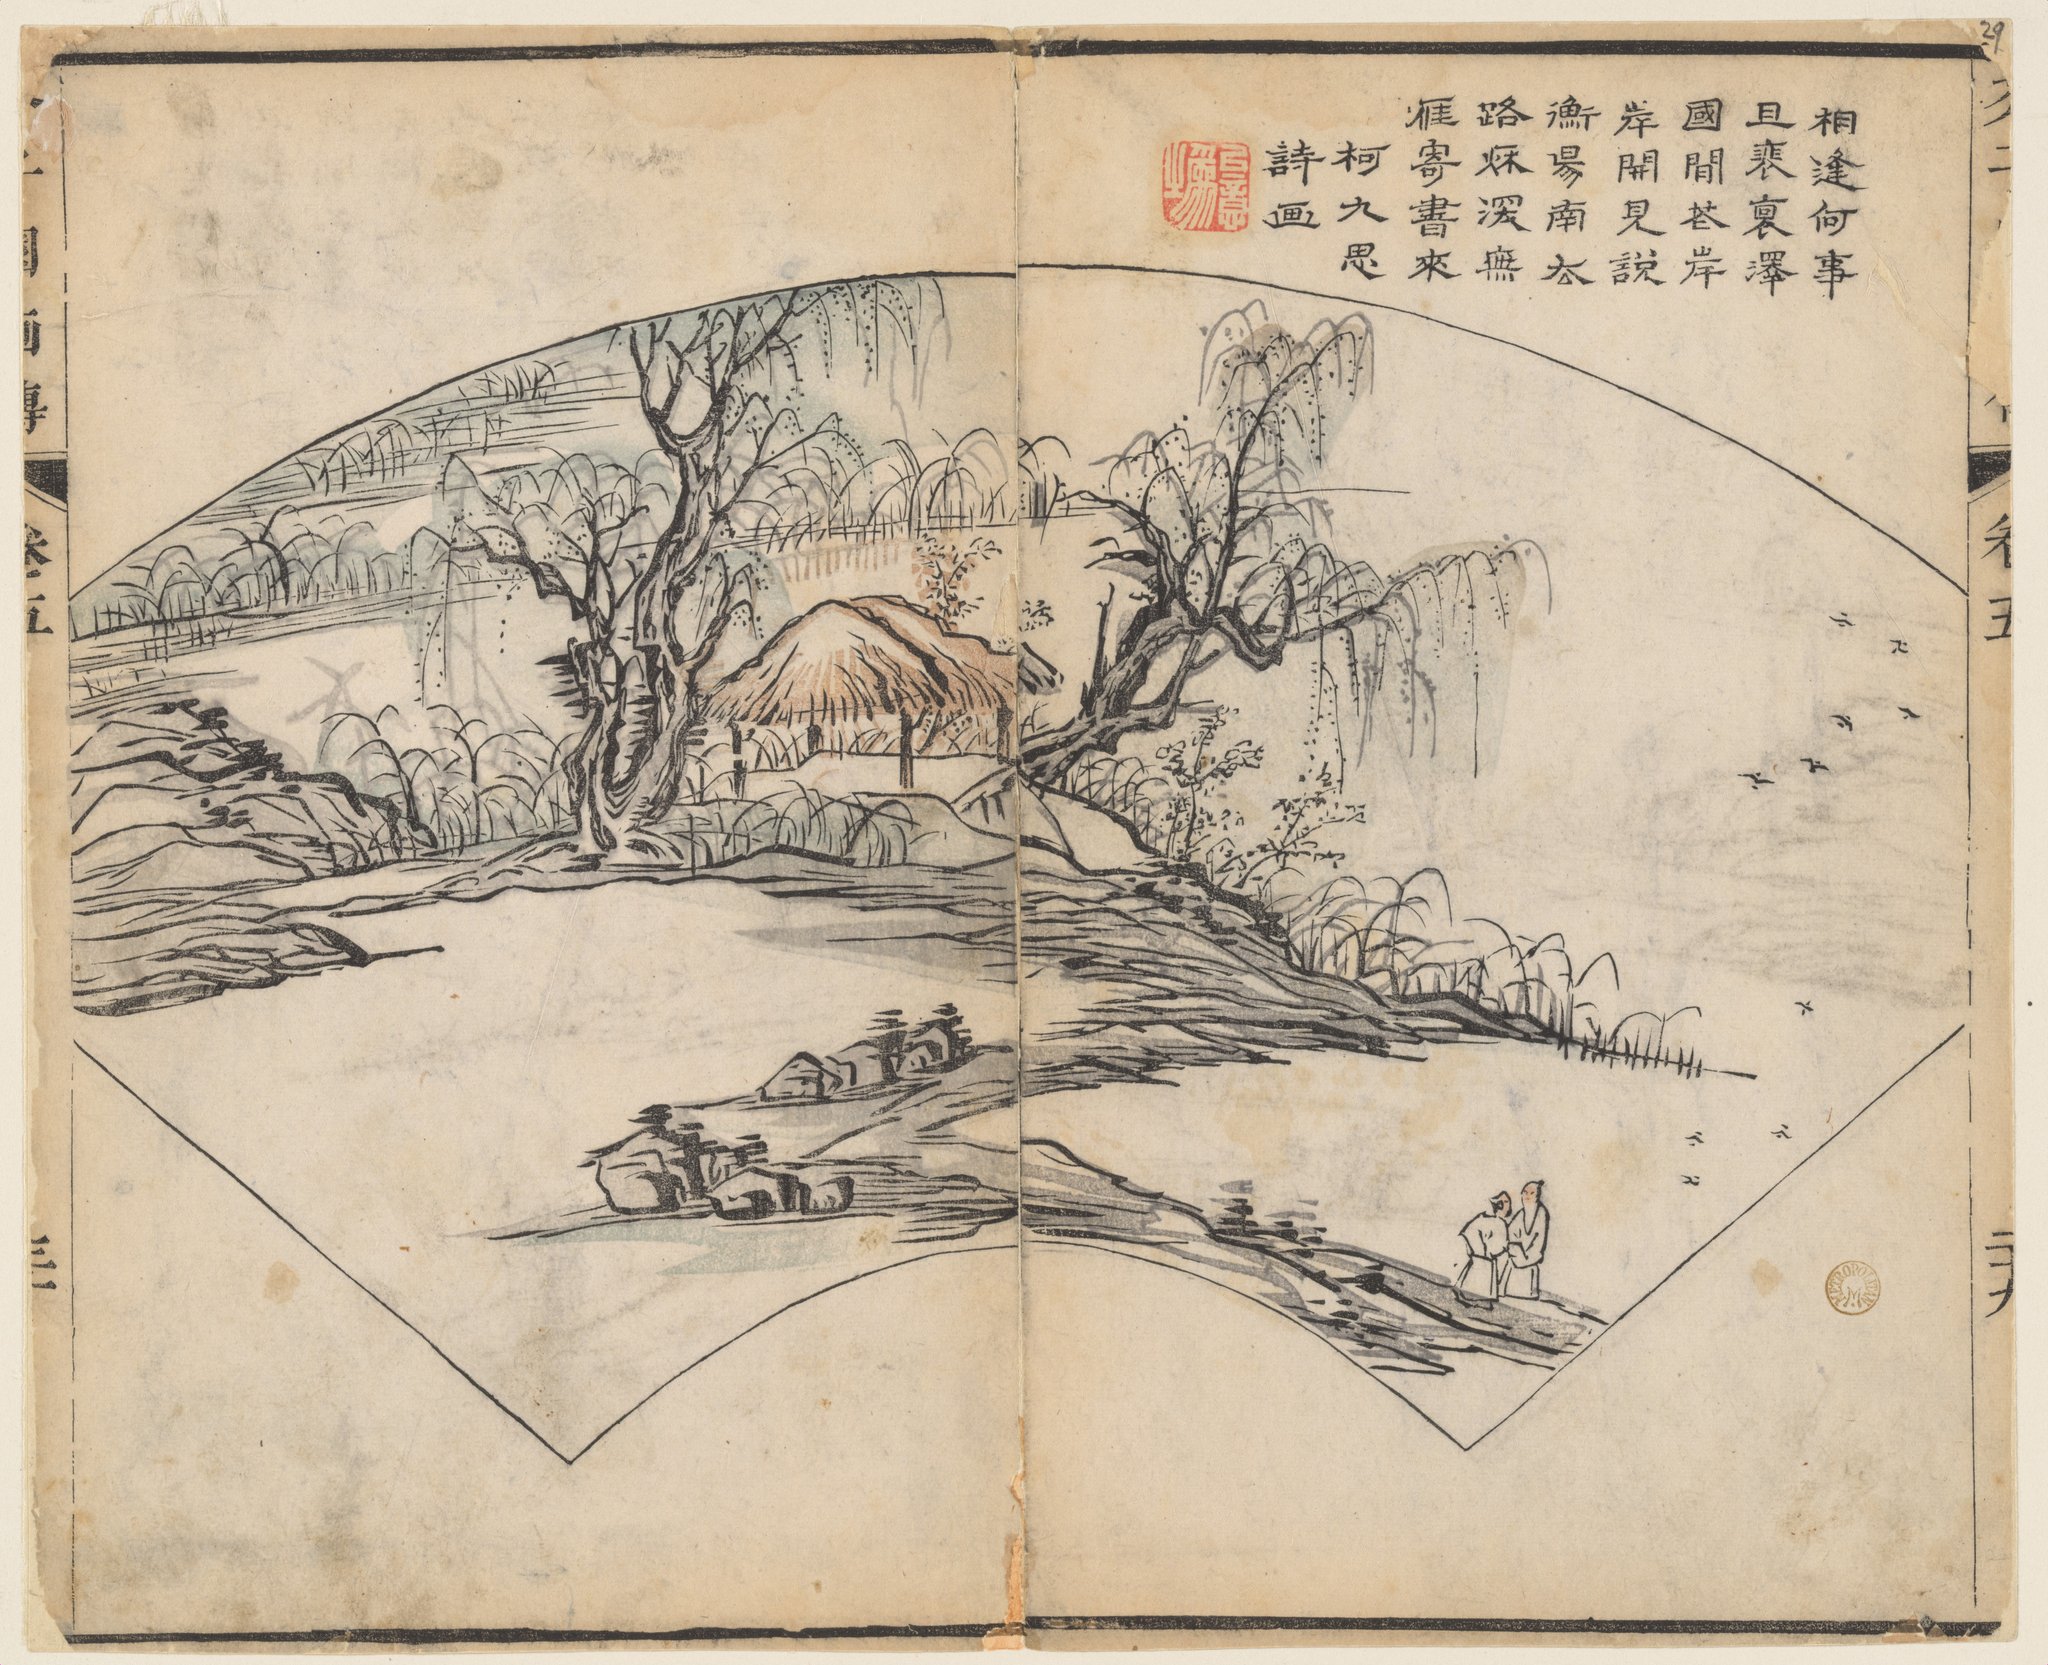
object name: print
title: Page from the Mustard Seed Garden Manual of Painting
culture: chinese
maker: wang gai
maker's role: artist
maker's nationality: chinese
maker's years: 1645-1710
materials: ink, paper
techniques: woodblock print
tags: landscapes